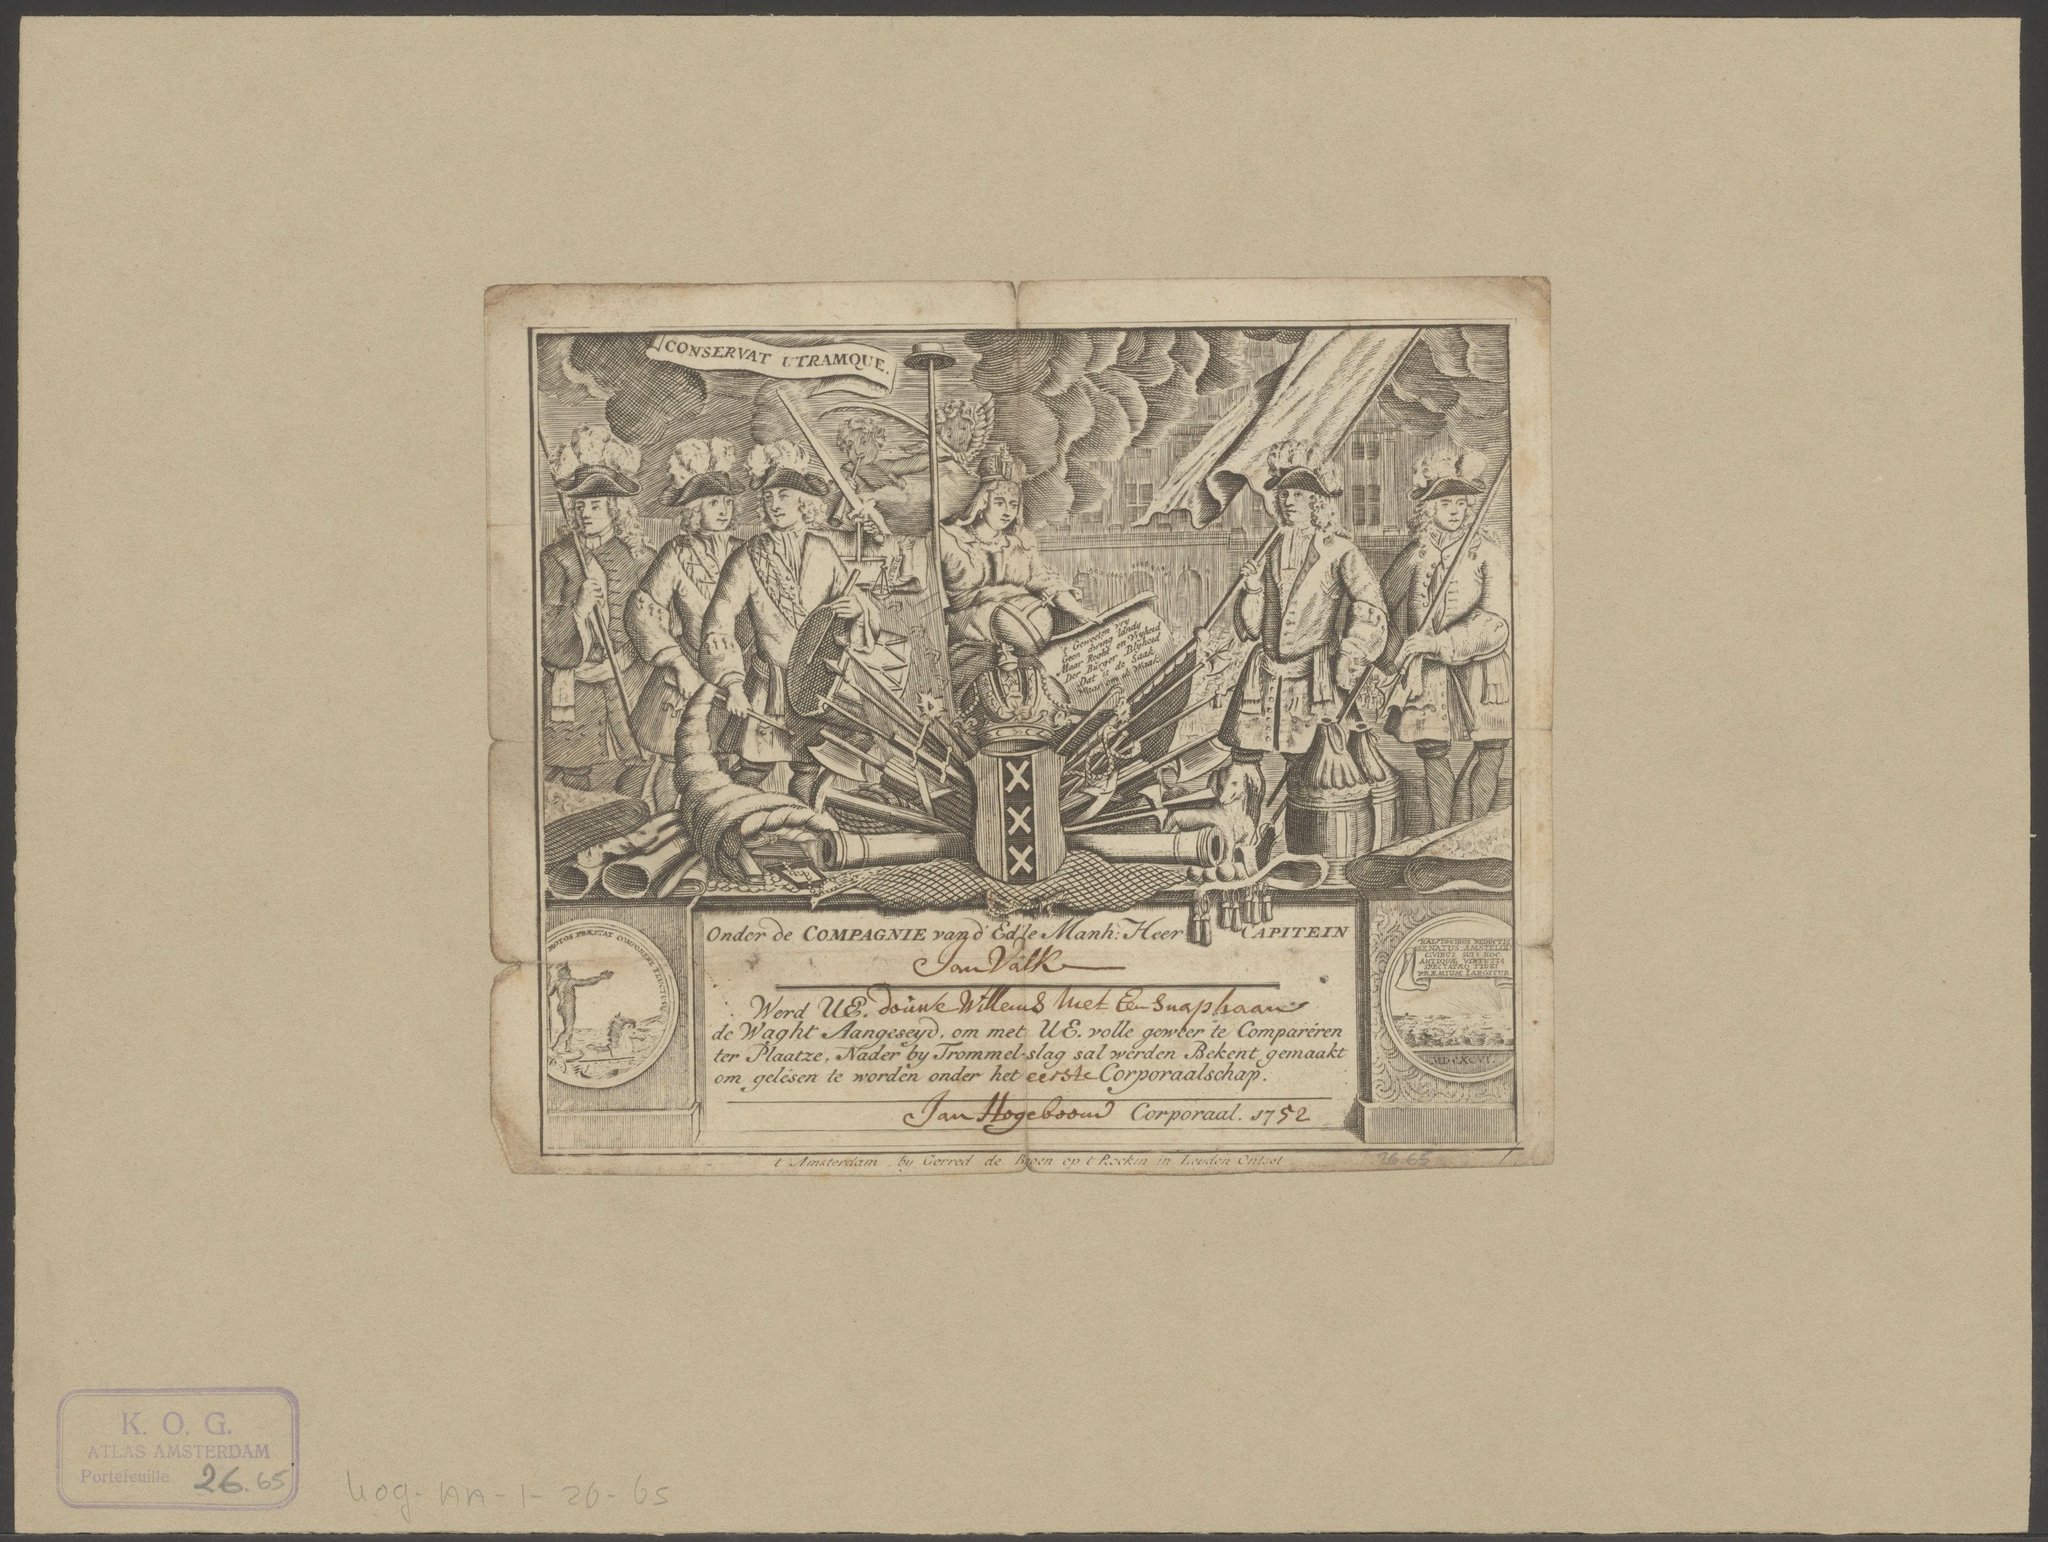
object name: schuttersbiljet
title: Schuttersbrief van kapitein Jan Valk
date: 1752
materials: paper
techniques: engraving, etching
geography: northern netherlands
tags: coat of arms (as symbol of the state, etc.) (+ city; municipal), personification of a city, town-patron(ess), military service (+ citizen soldiery, civil guard, citizen militia), amsterdam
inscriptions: collector's mark: Lugt 1641b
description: Schuttersbrief met oproep van kapitein Jan Valk, gericht aan Douwe Willems met een snaphaan, om zich bij het eerste korporaalschap van Jan Hogeboom van de Amsterdamse schutterij te melden. Voorgedrukte brief met open delen die met pen zijn ingevuld. Onderwerpsrubriek binnen de Atlas Amsterdam: Schutters-oproepingsbriefjes.